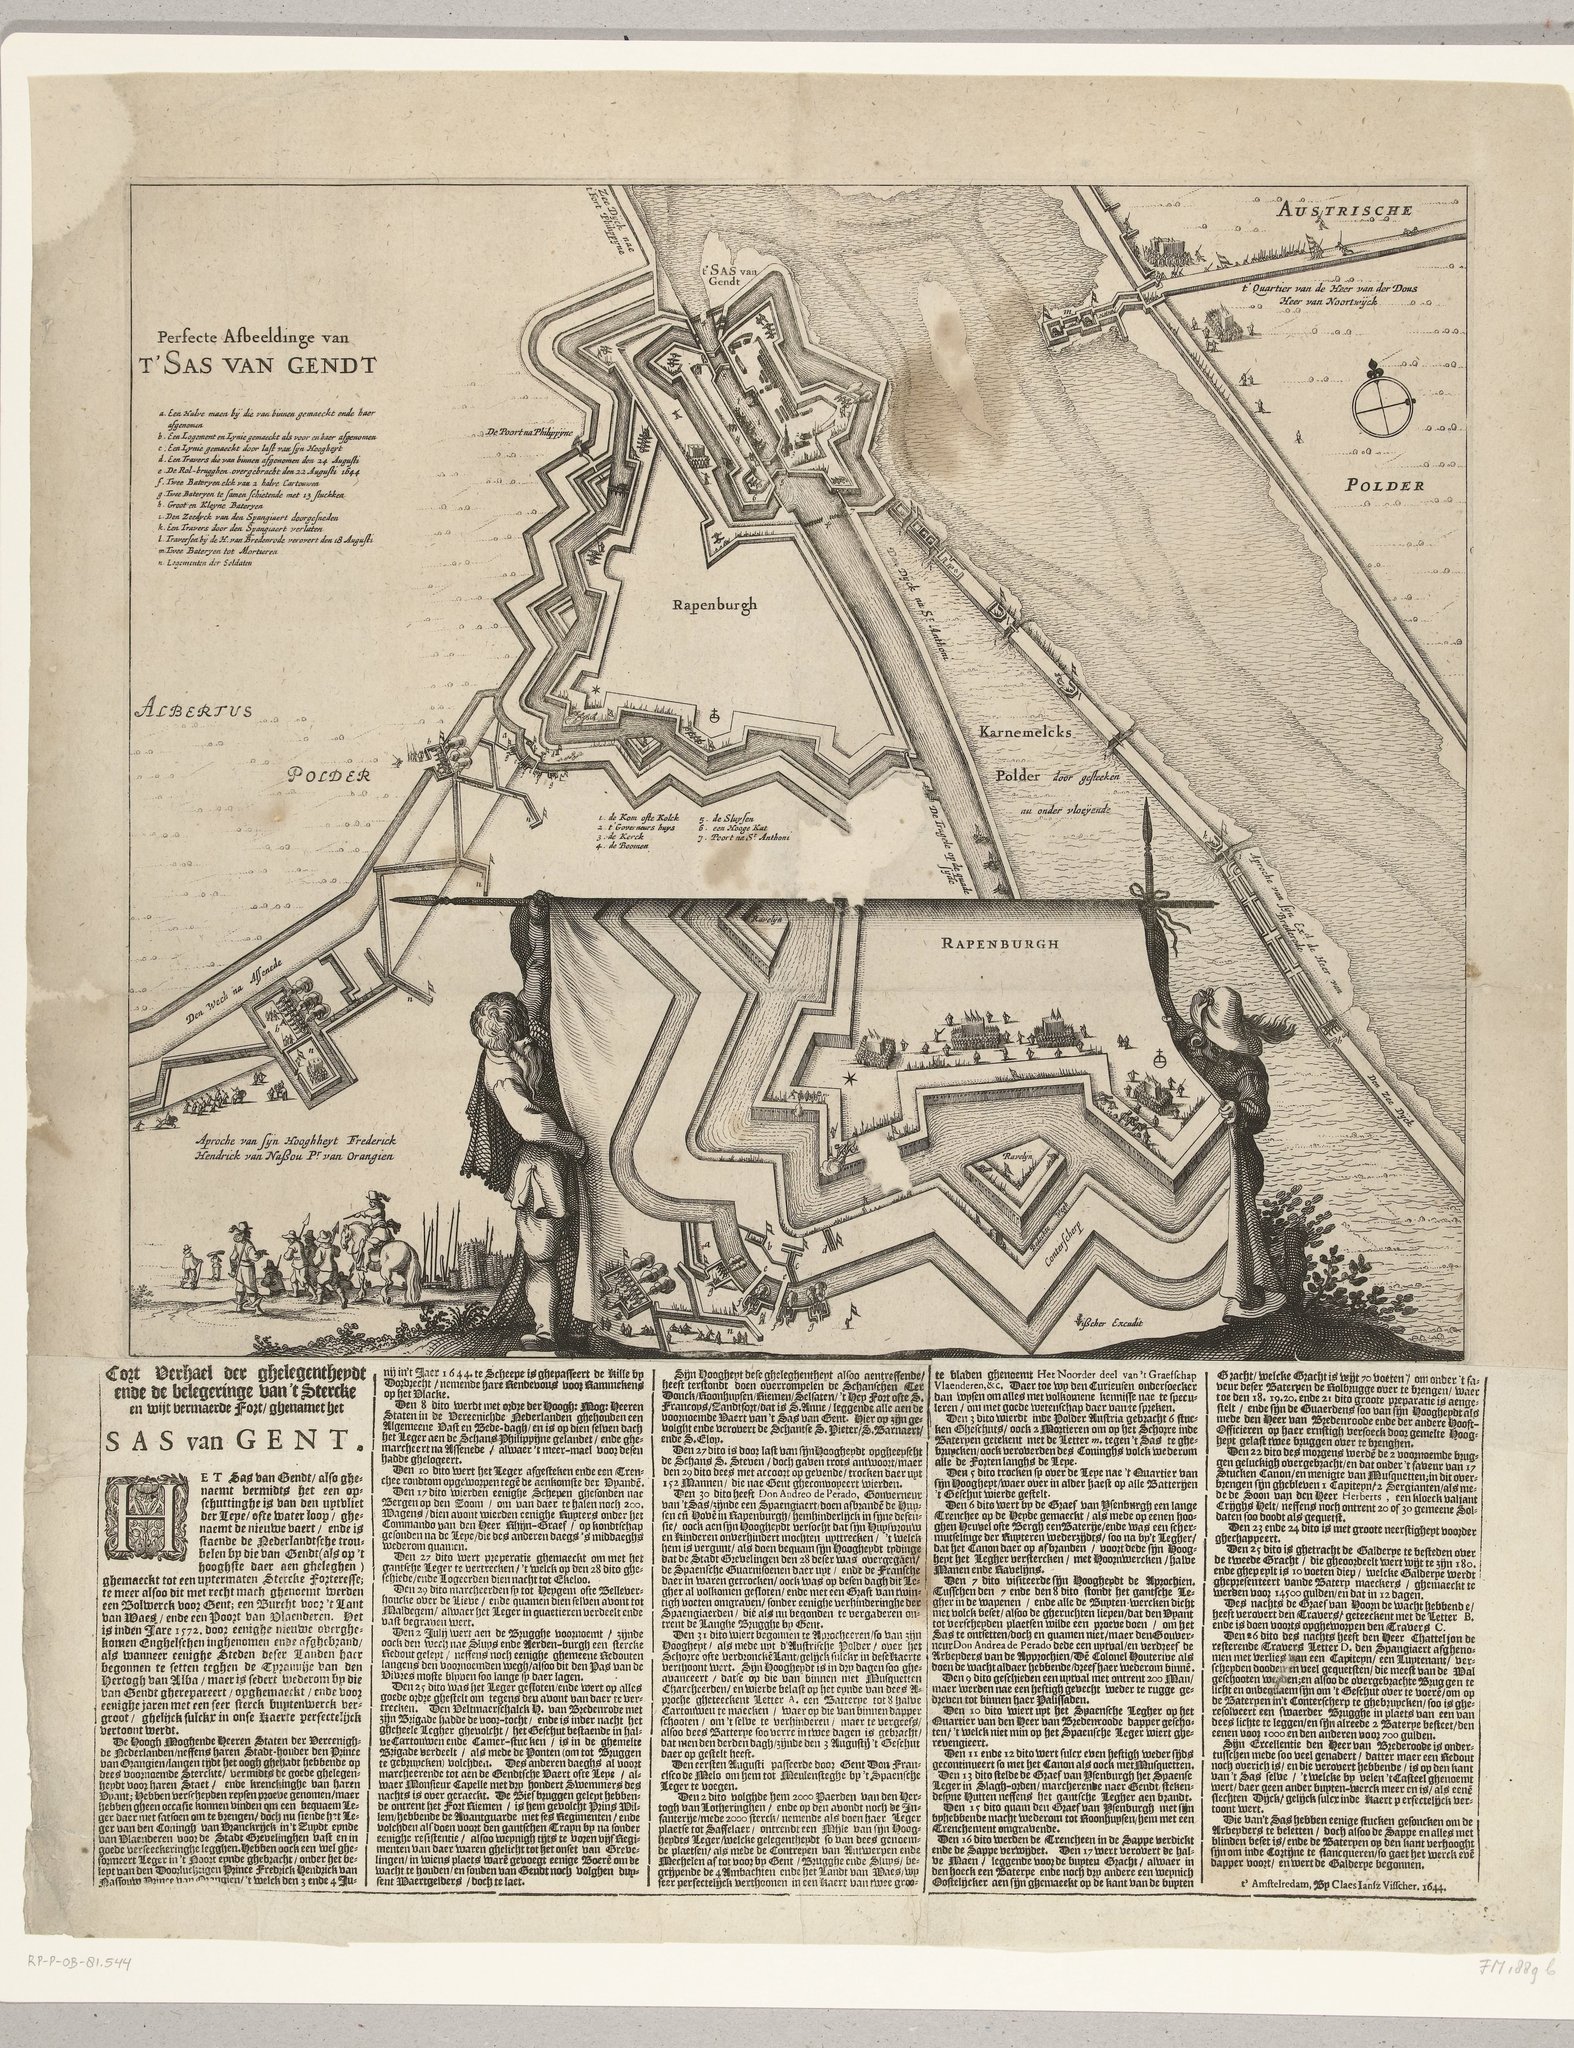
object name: print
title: Plattegrond van het belegerde Sas van Gent, 1644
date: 1644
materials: paper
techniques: engraving, etching, letterpress printing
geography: amsterdam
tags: frederick henry (prince of orange), fortress, siege, position war, maps of cities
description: Plattegrond van Sas van Gent, belegerd door het Staatse leger onder Frederik Hendrik, begonnen 28 juli en ingenomen op 5 september 1644. Plattegrond van de versterkingen rond Sas-van-Gent, onderaan twee mannen met een doek waarop een uitvergroot detail van de beschietingen bij de ravelijnen bij het Rapenburg. Linksboven de titel en de legenda a-n. Onder de prent is een tekstblad geplakt met 5 kolommen tekst in het Nederlands.